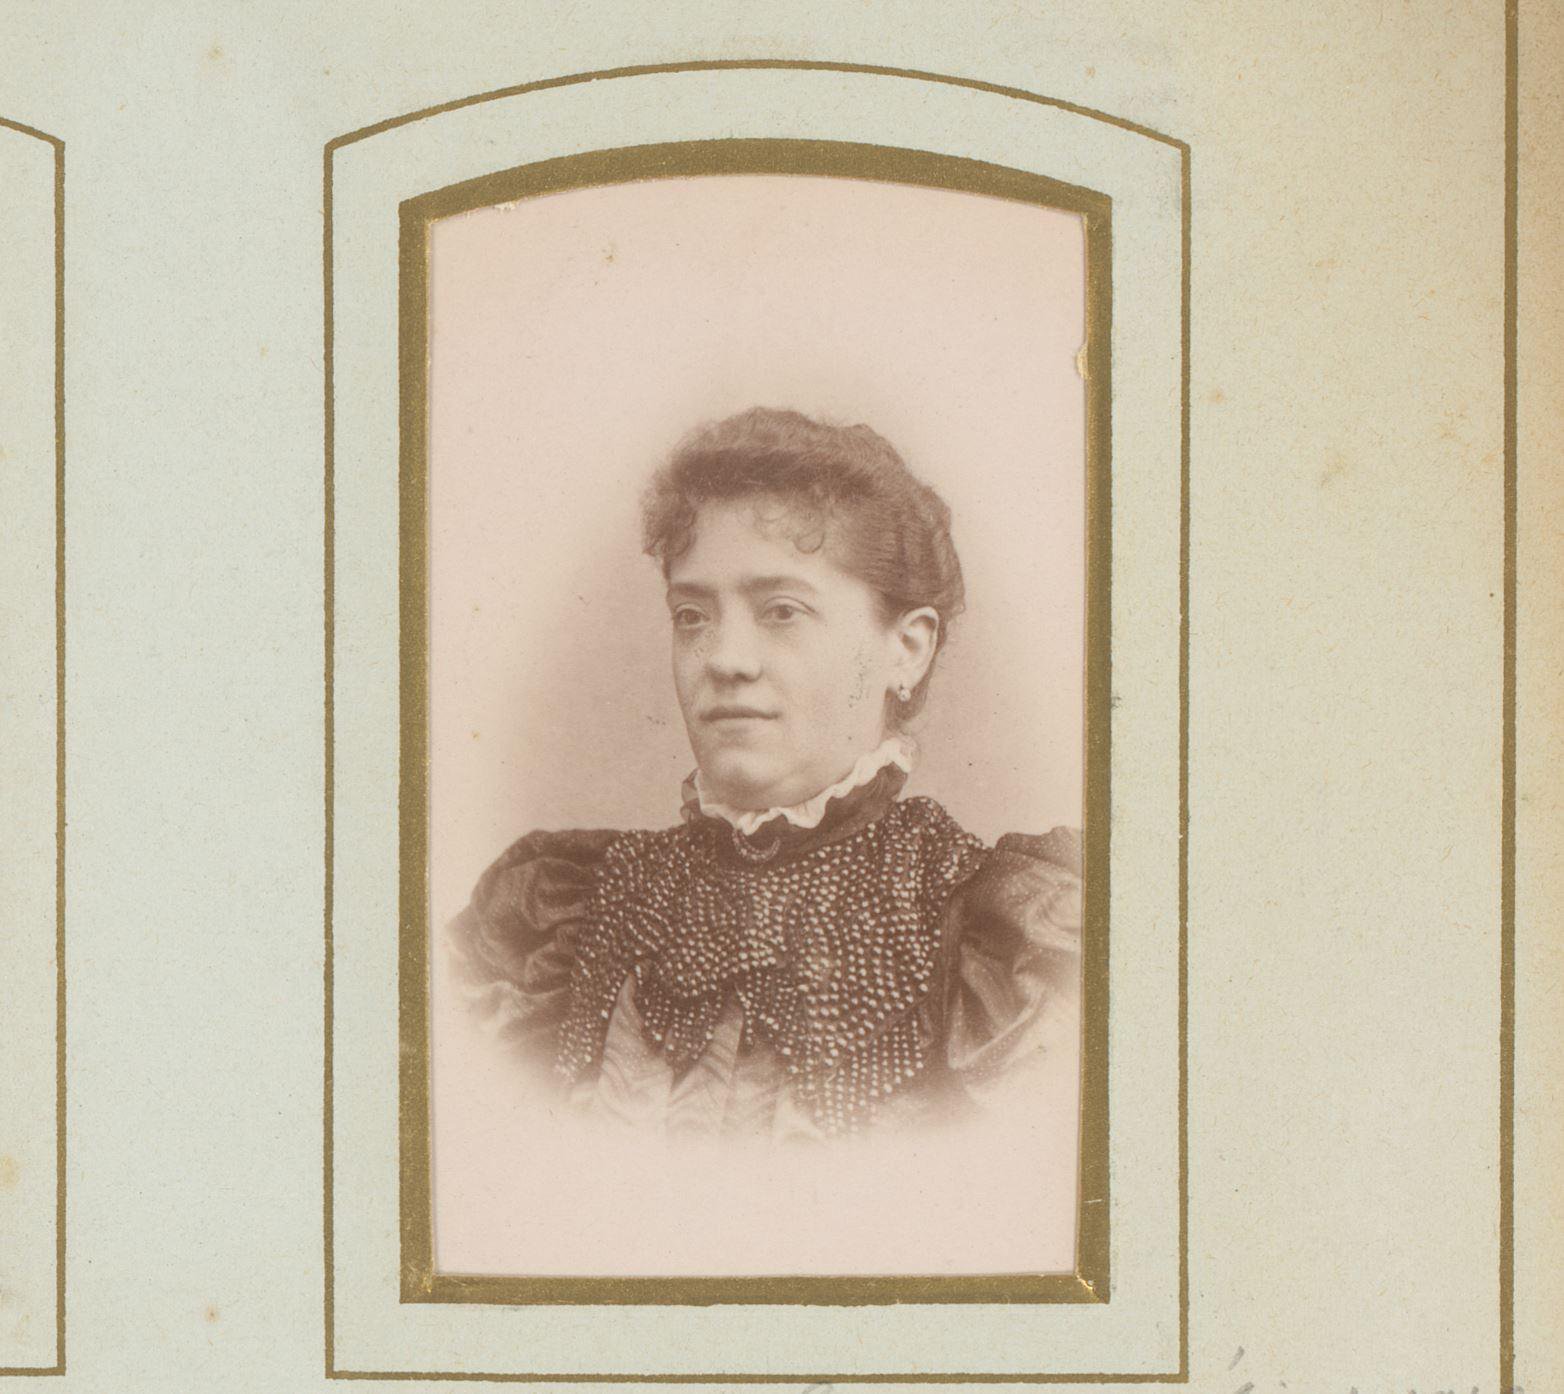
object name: photograph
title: Portret van Jeanne Ernie-Guétin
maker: louis larger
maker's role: fotograaf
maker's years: 1849-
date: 1880-1920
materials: cardboard, photographic support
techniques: collodion silver print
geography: paris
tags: historical persons - bb - woman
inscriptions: name: ‘Jeanne Ernie-Guétin +1949’, inscription: ‘Grand-Prix/ Plusieurs Fois Membre du Jury/ Hors Concours/ PHOTOTYPIE-HÉLIOTYPIE/ Impression Rapide aux Encres Grasses/ Ancne. Mon. JAMIN/ L. LARGER Sr./ 13, Rue Chapon, 13/ PARIS’